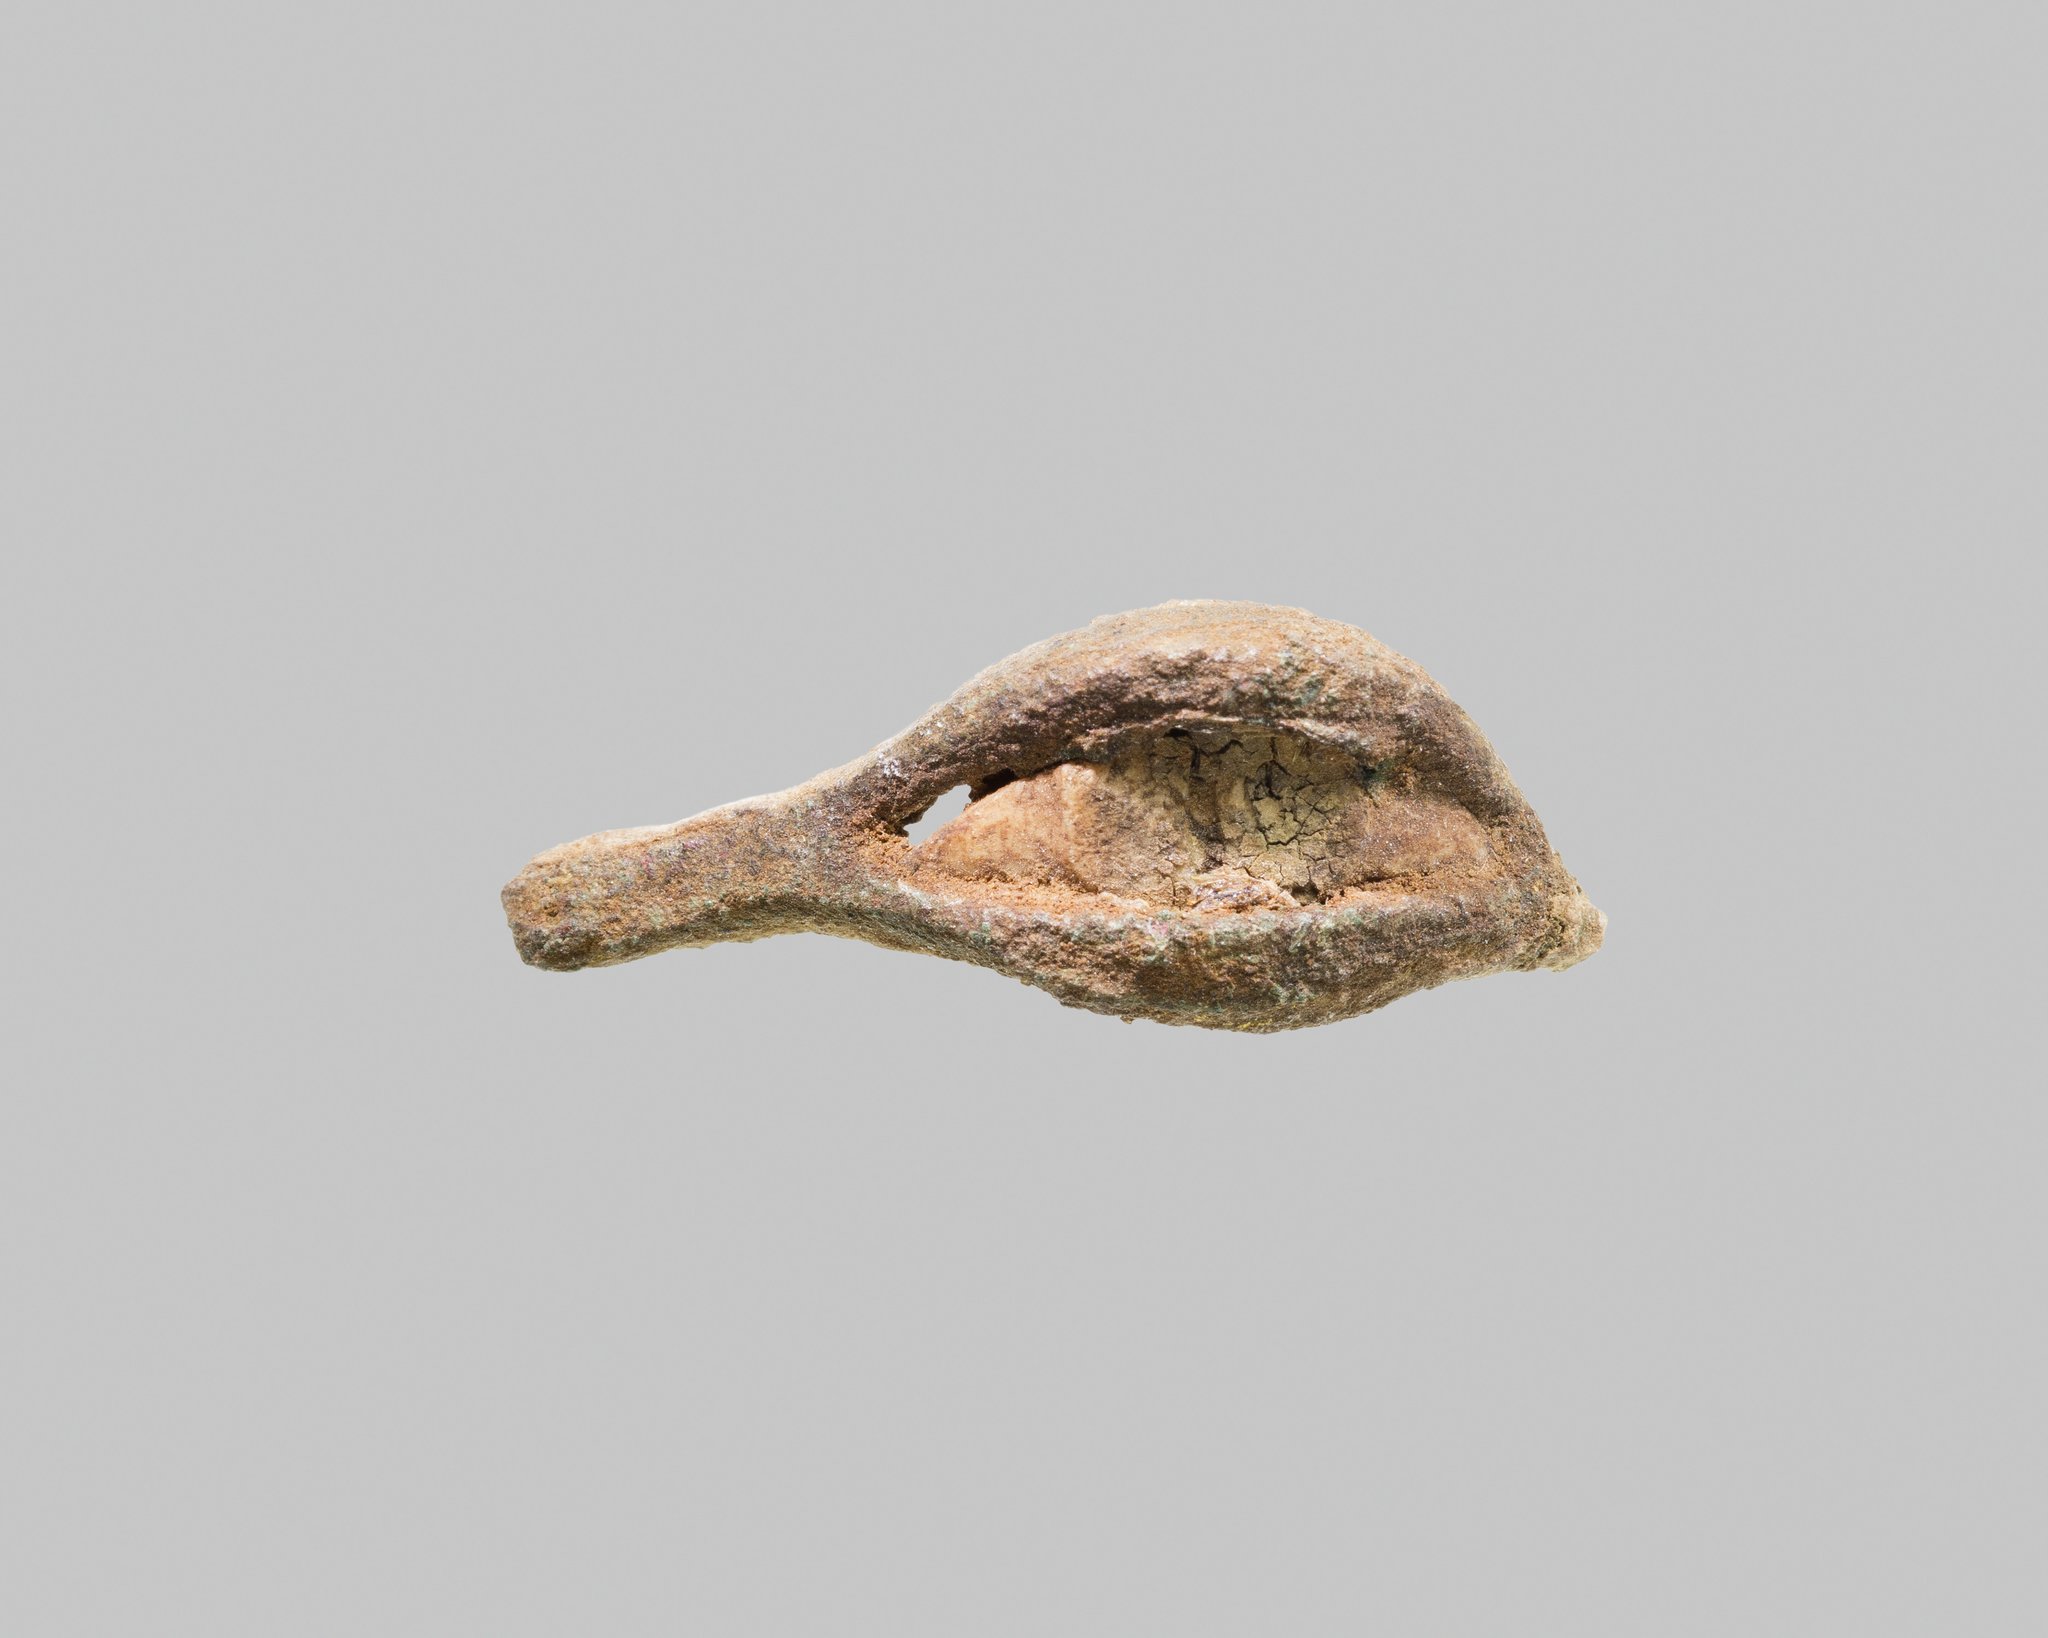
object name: statuette fragment, eye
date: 712-30 BCE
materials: bronze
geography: egypt